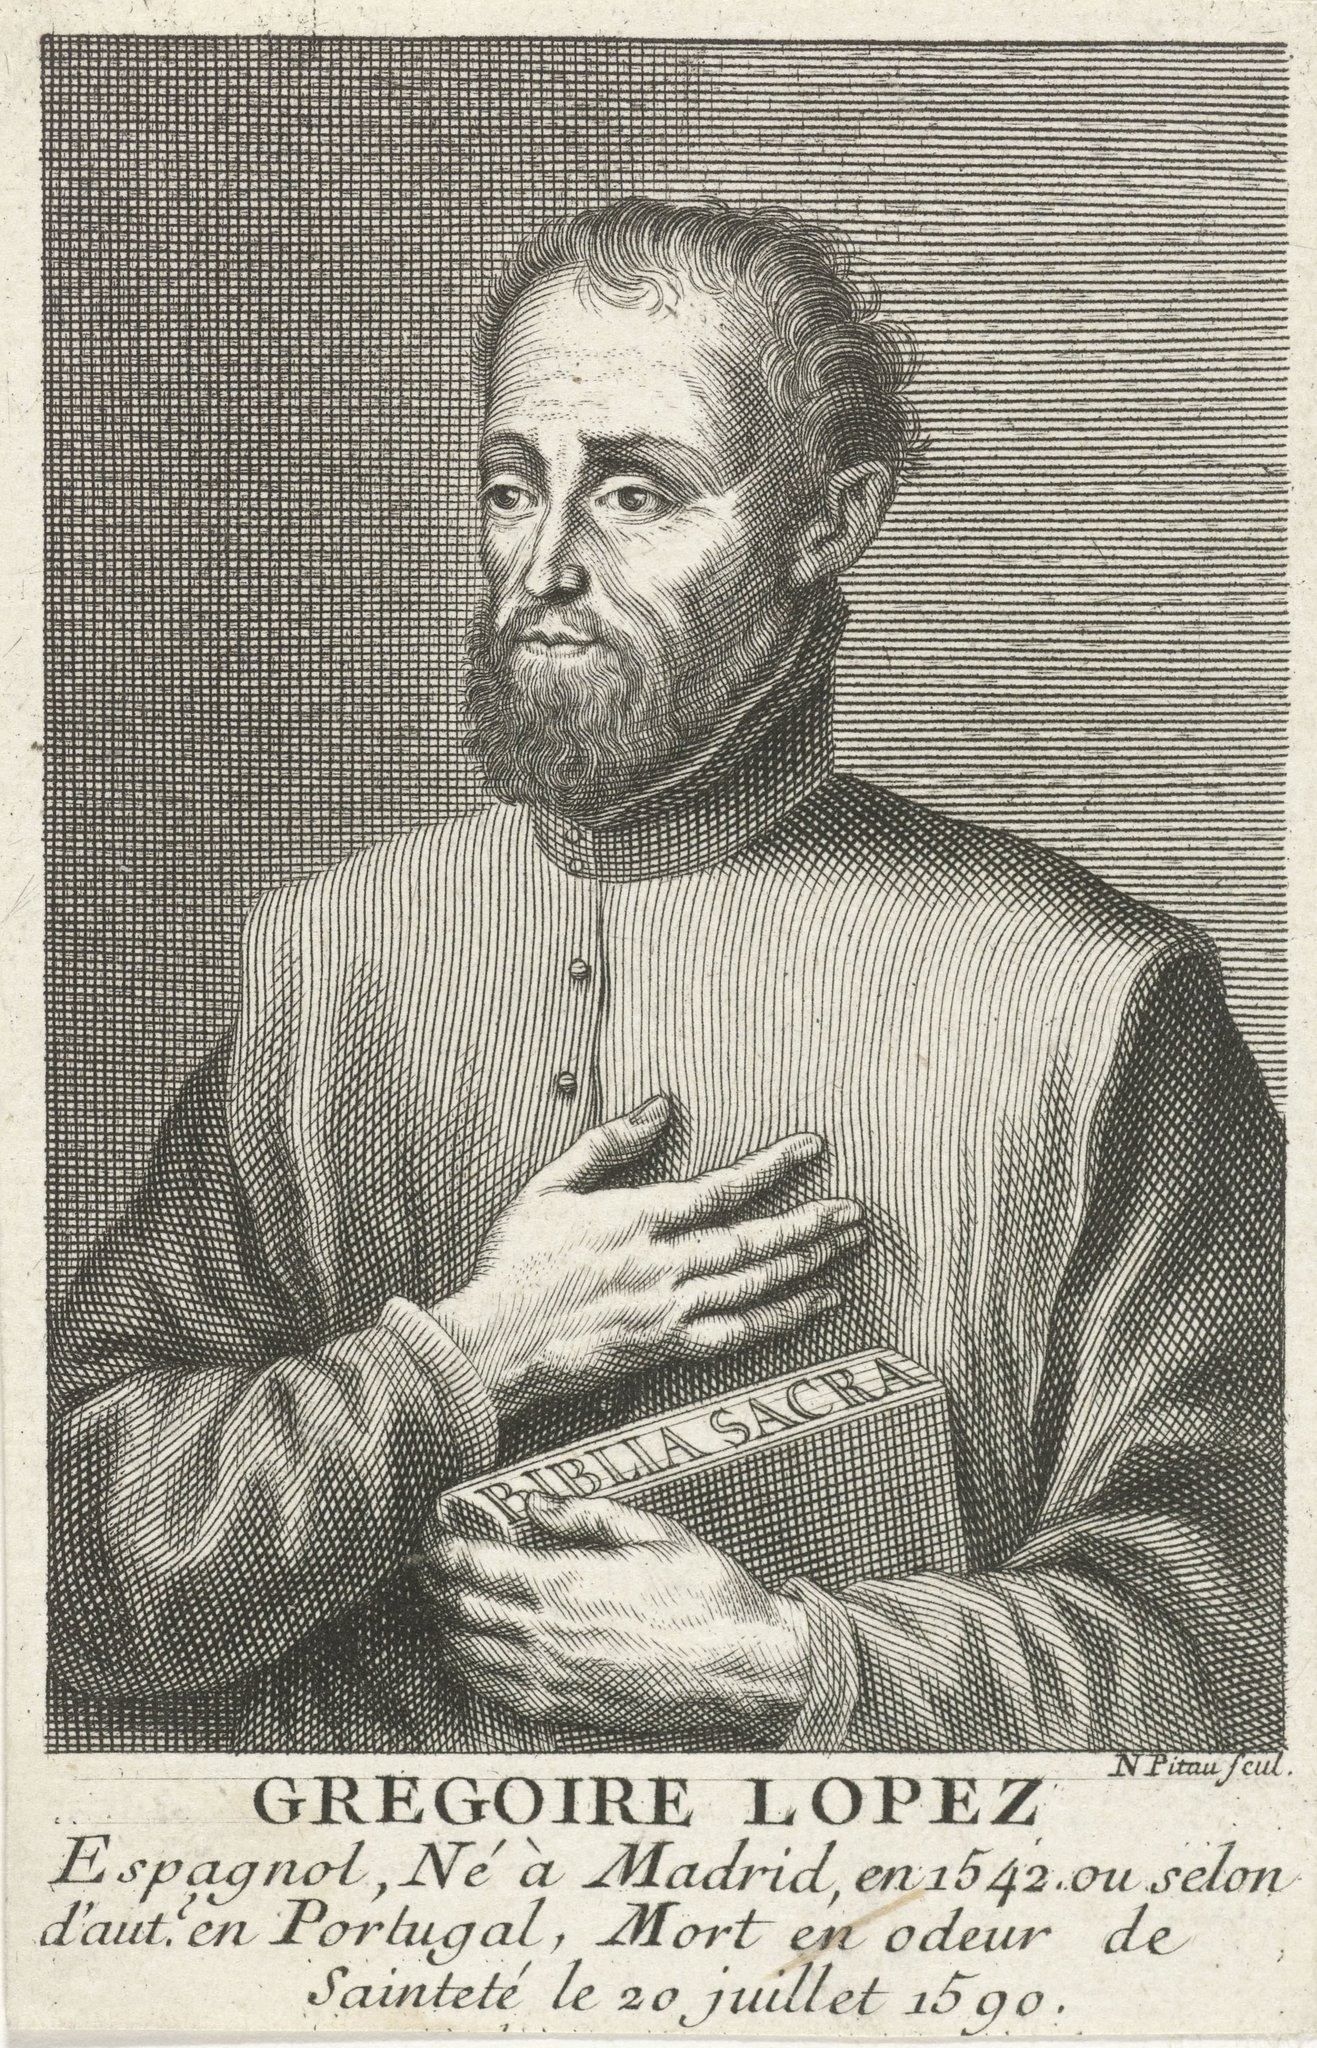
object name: print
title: Portret van Gregoire Lopez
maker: nicolas pitau (i)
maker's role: print maker, publisher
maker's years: 1632-1671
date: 1644-1671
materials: paper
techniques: engraving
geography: paris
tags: the bible as a book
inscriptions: collector's mark: Lugt 2228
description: Portret van Gregoire Lopez. Hij houdt een bijbel in de hand. In de marge een drieregelig onderschrift in het Frans.